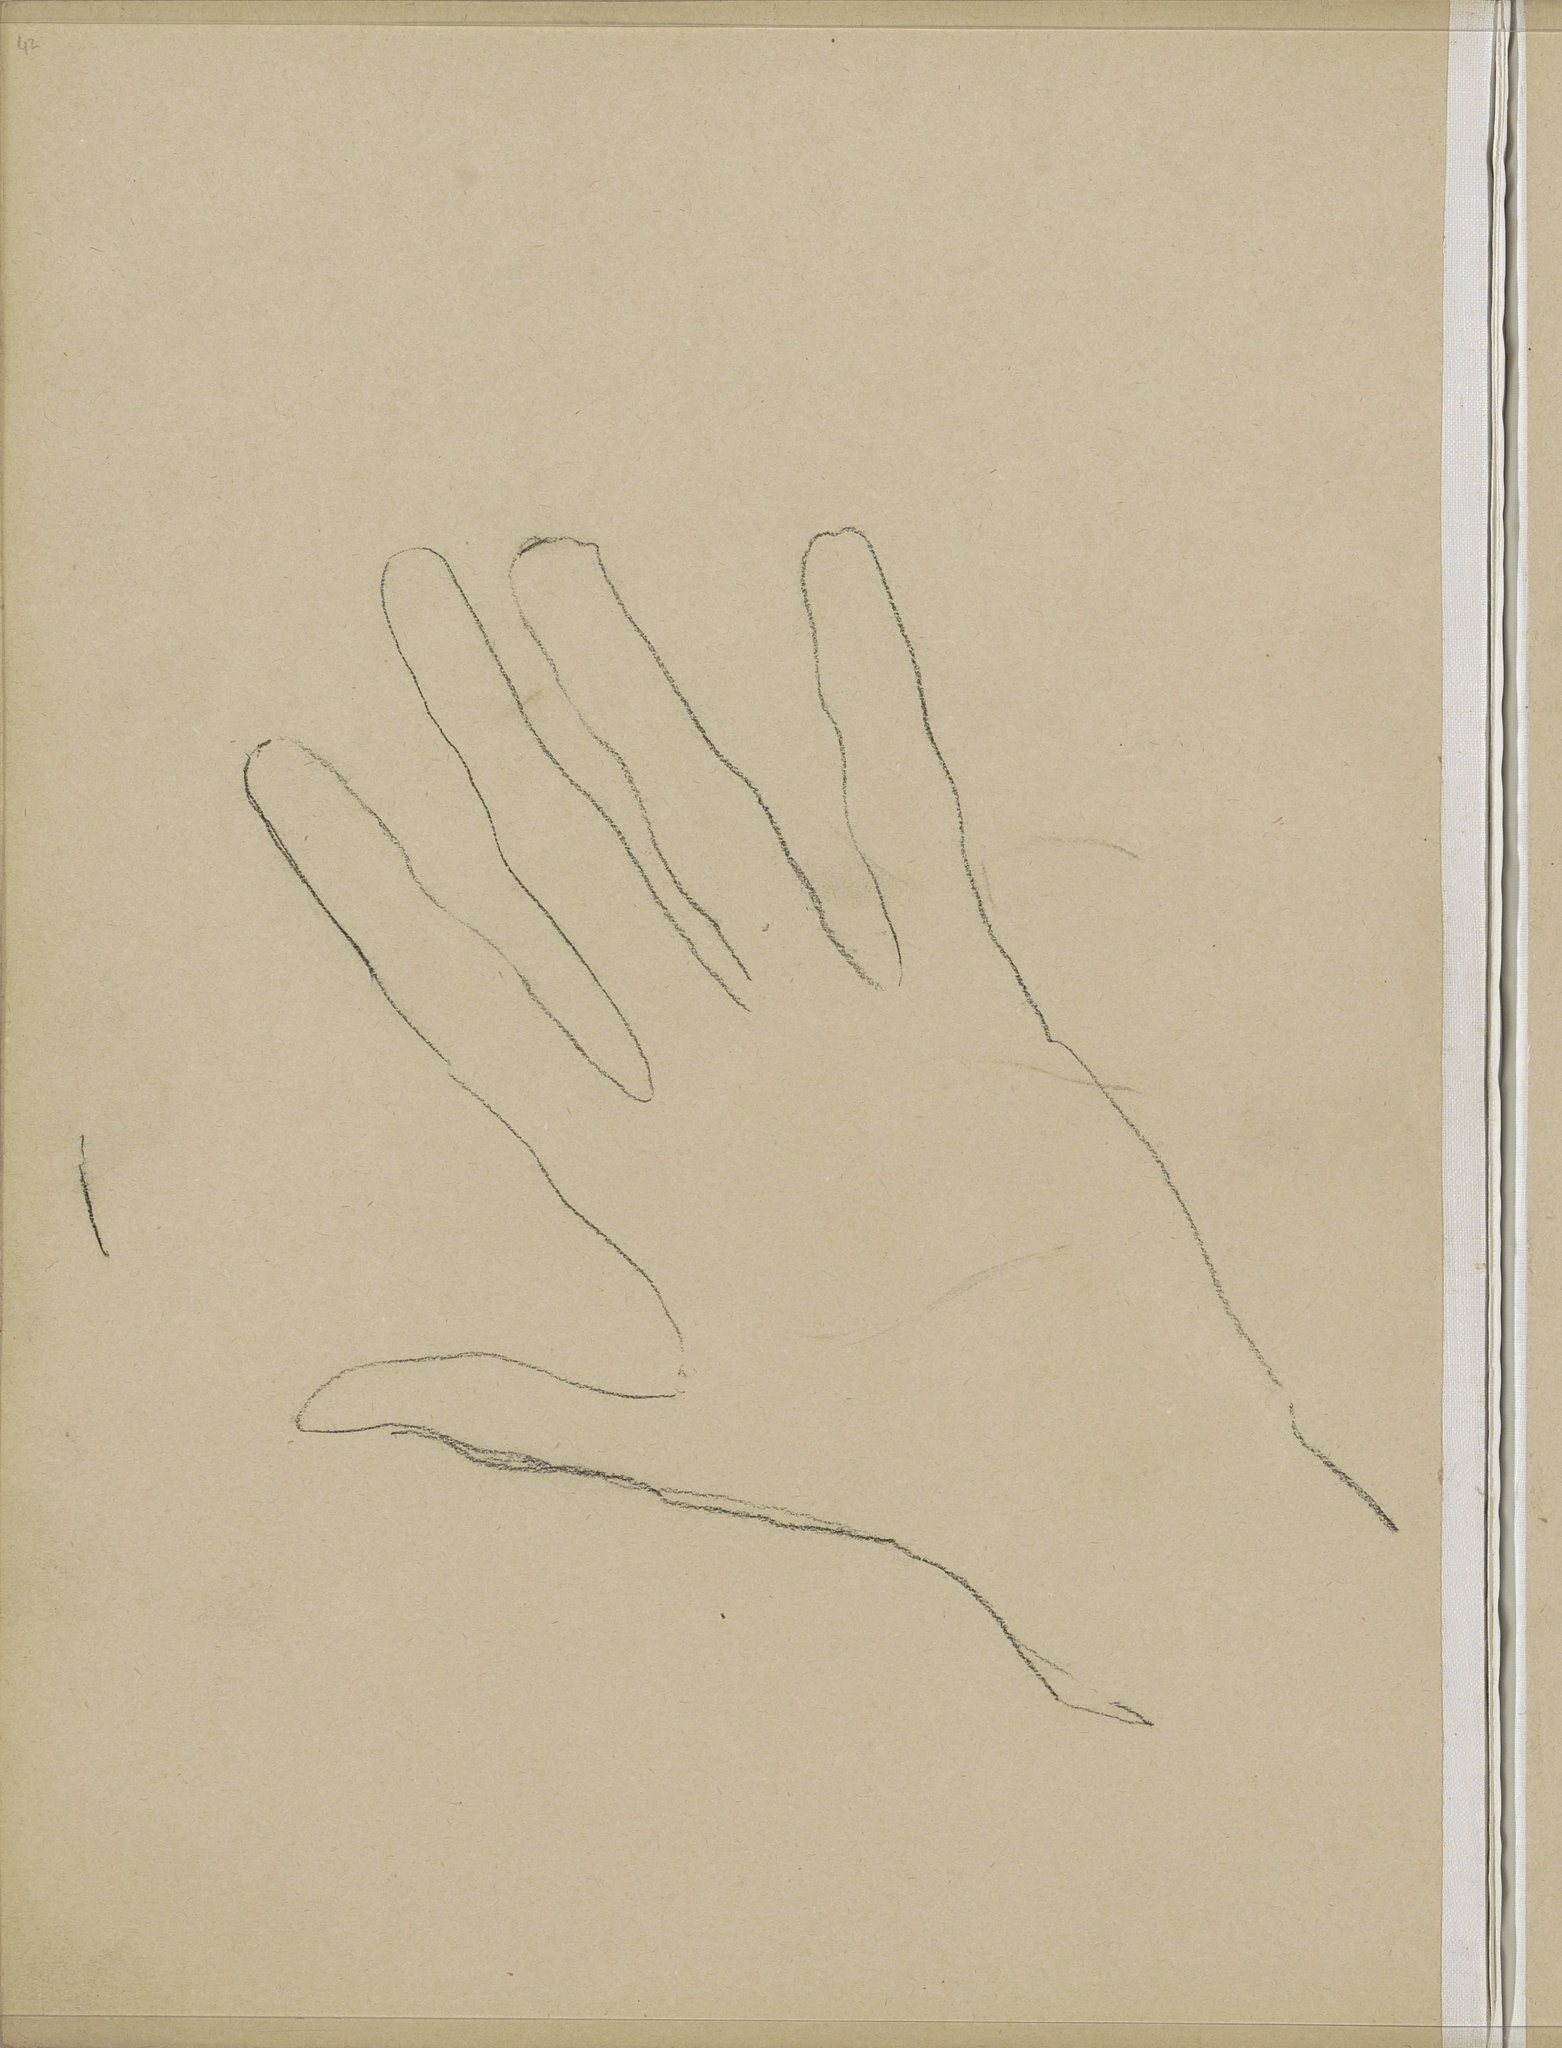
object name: sketchbook leaf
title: Hand met gespreide vingers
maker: willem witsen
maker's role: draughtsman, painter, print maker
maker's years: 1860-1923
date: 1874-1923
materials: chalk, paper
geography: ewijkshoeve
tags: hand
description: Pagina 42 uit een schetsboek met 72 bladen.